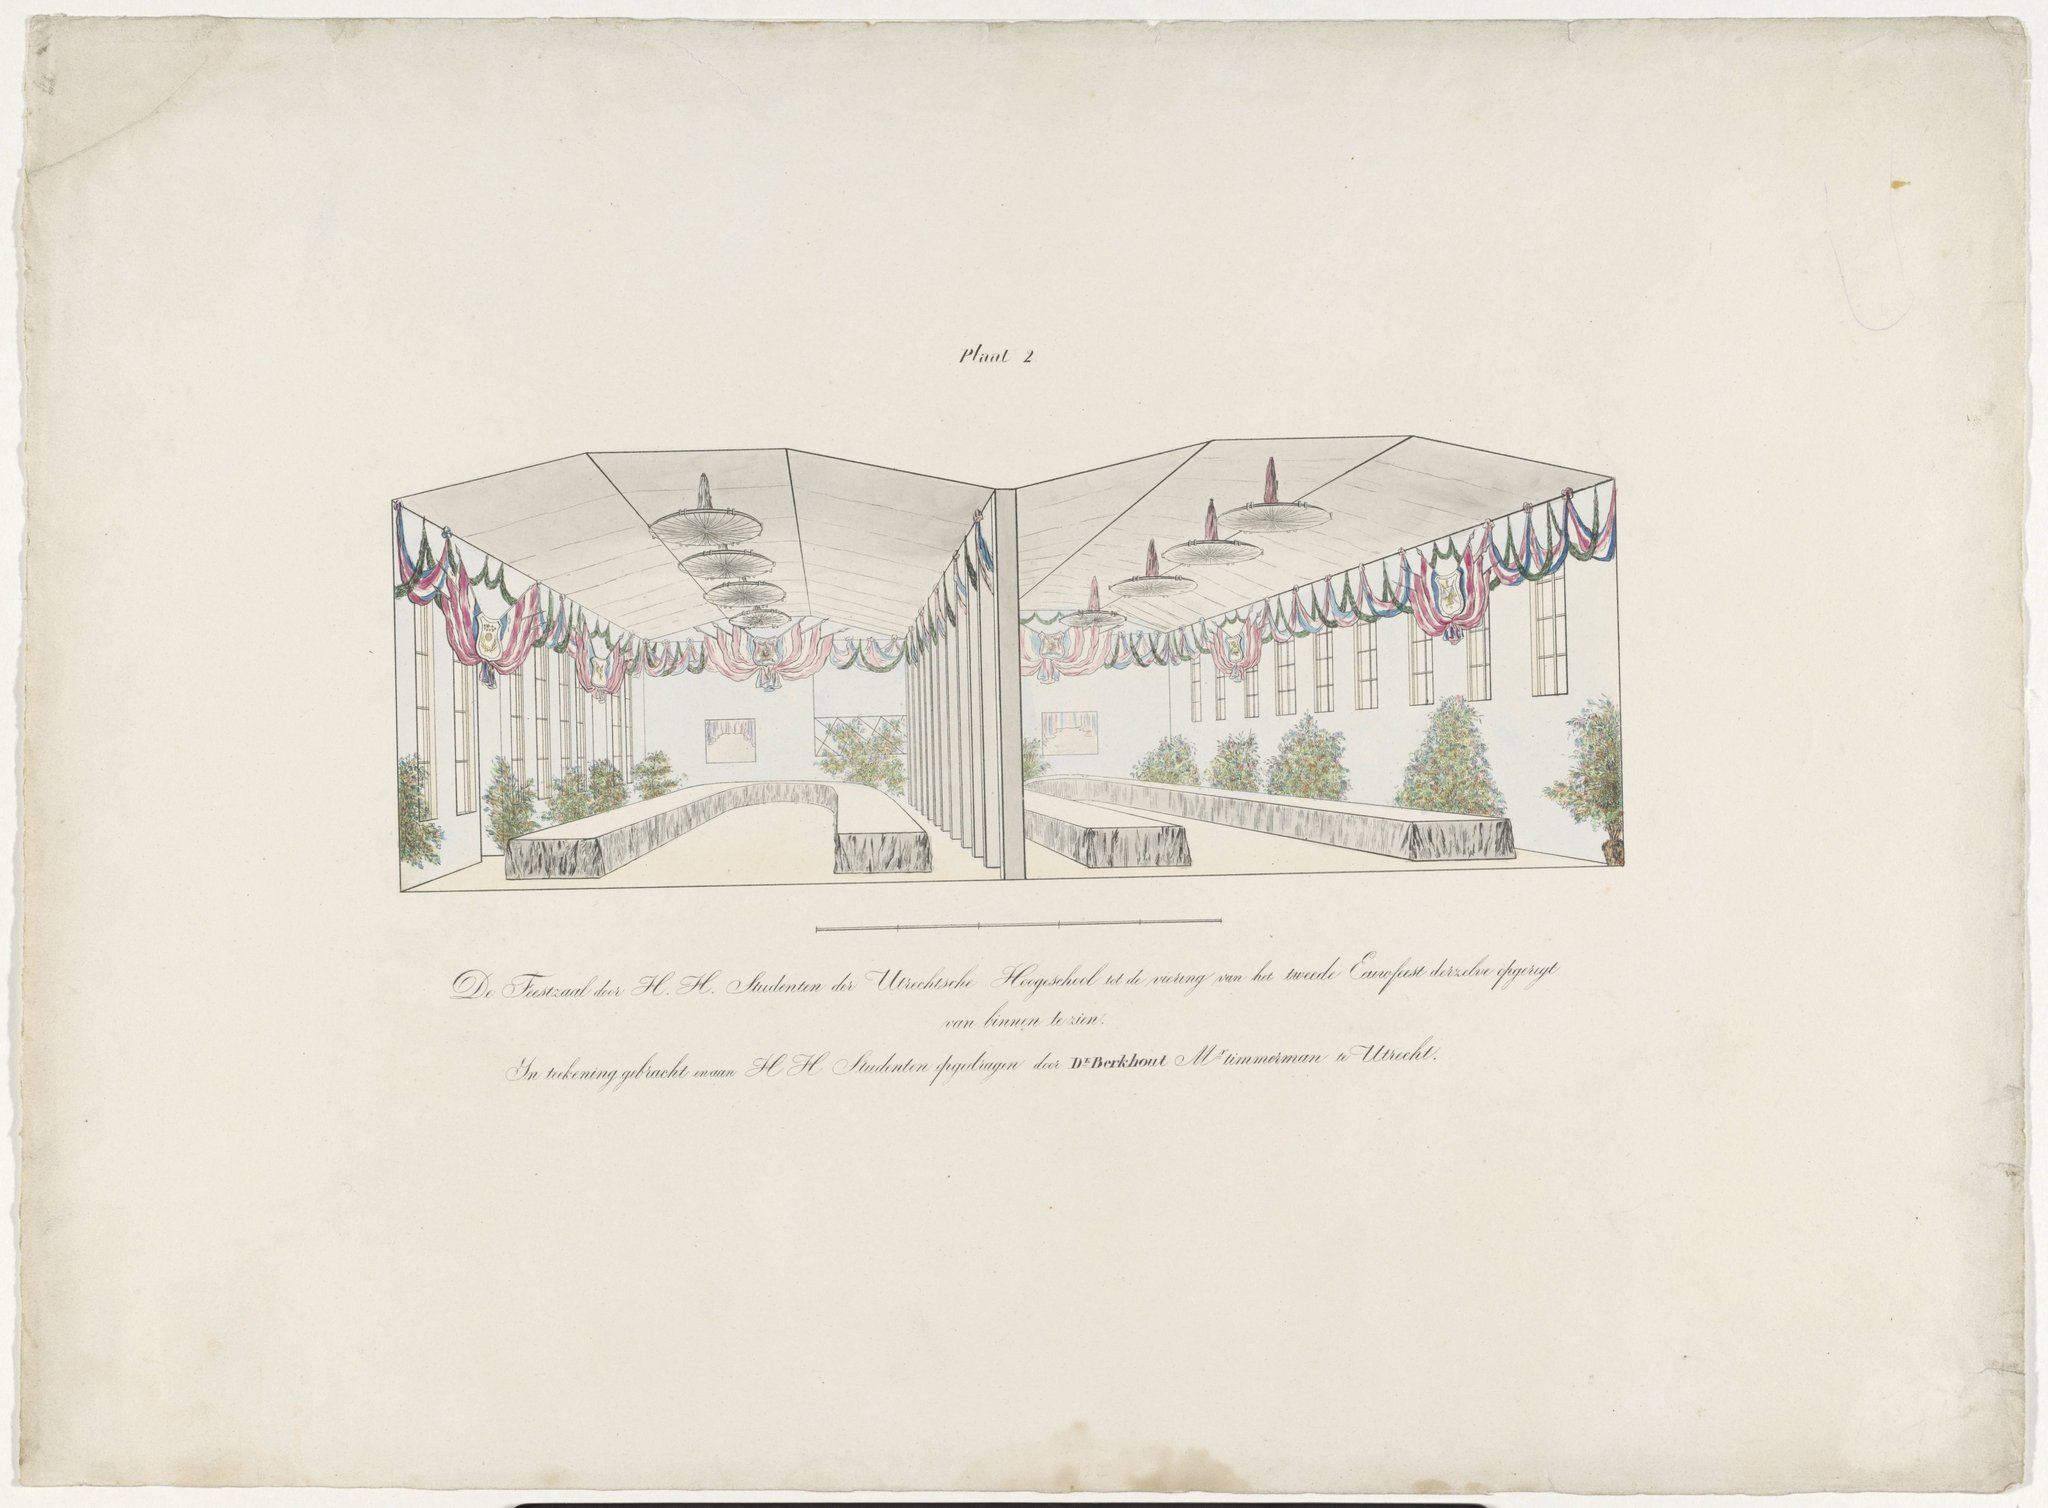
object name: print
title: De Feestzaal der H.H. Studenten der Utrechtsche Hoogeschool tot de viering van het tweede Eeuwfeest derzelve opgerigt van binnen te zien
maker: dk. berkhout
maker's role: draughtsman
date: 1836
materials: paper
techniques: hand coloring, lithograph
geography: utrecht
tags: commemoration of the founding of a university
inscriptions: collector's mark: Lugt 2228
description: De Atlas van Stolk bezit een exemplaar van een deze twee prenten in een omslag waarop staat vermeld 'Uit de steendrukkerij van Gebr.s van de Weijer' en 'Geteekend en uitgegeven door D.k Berkhout Mr timmerman te Utrecht.' Niet in Frederik Muller; door het RPK toegevoegd nummer